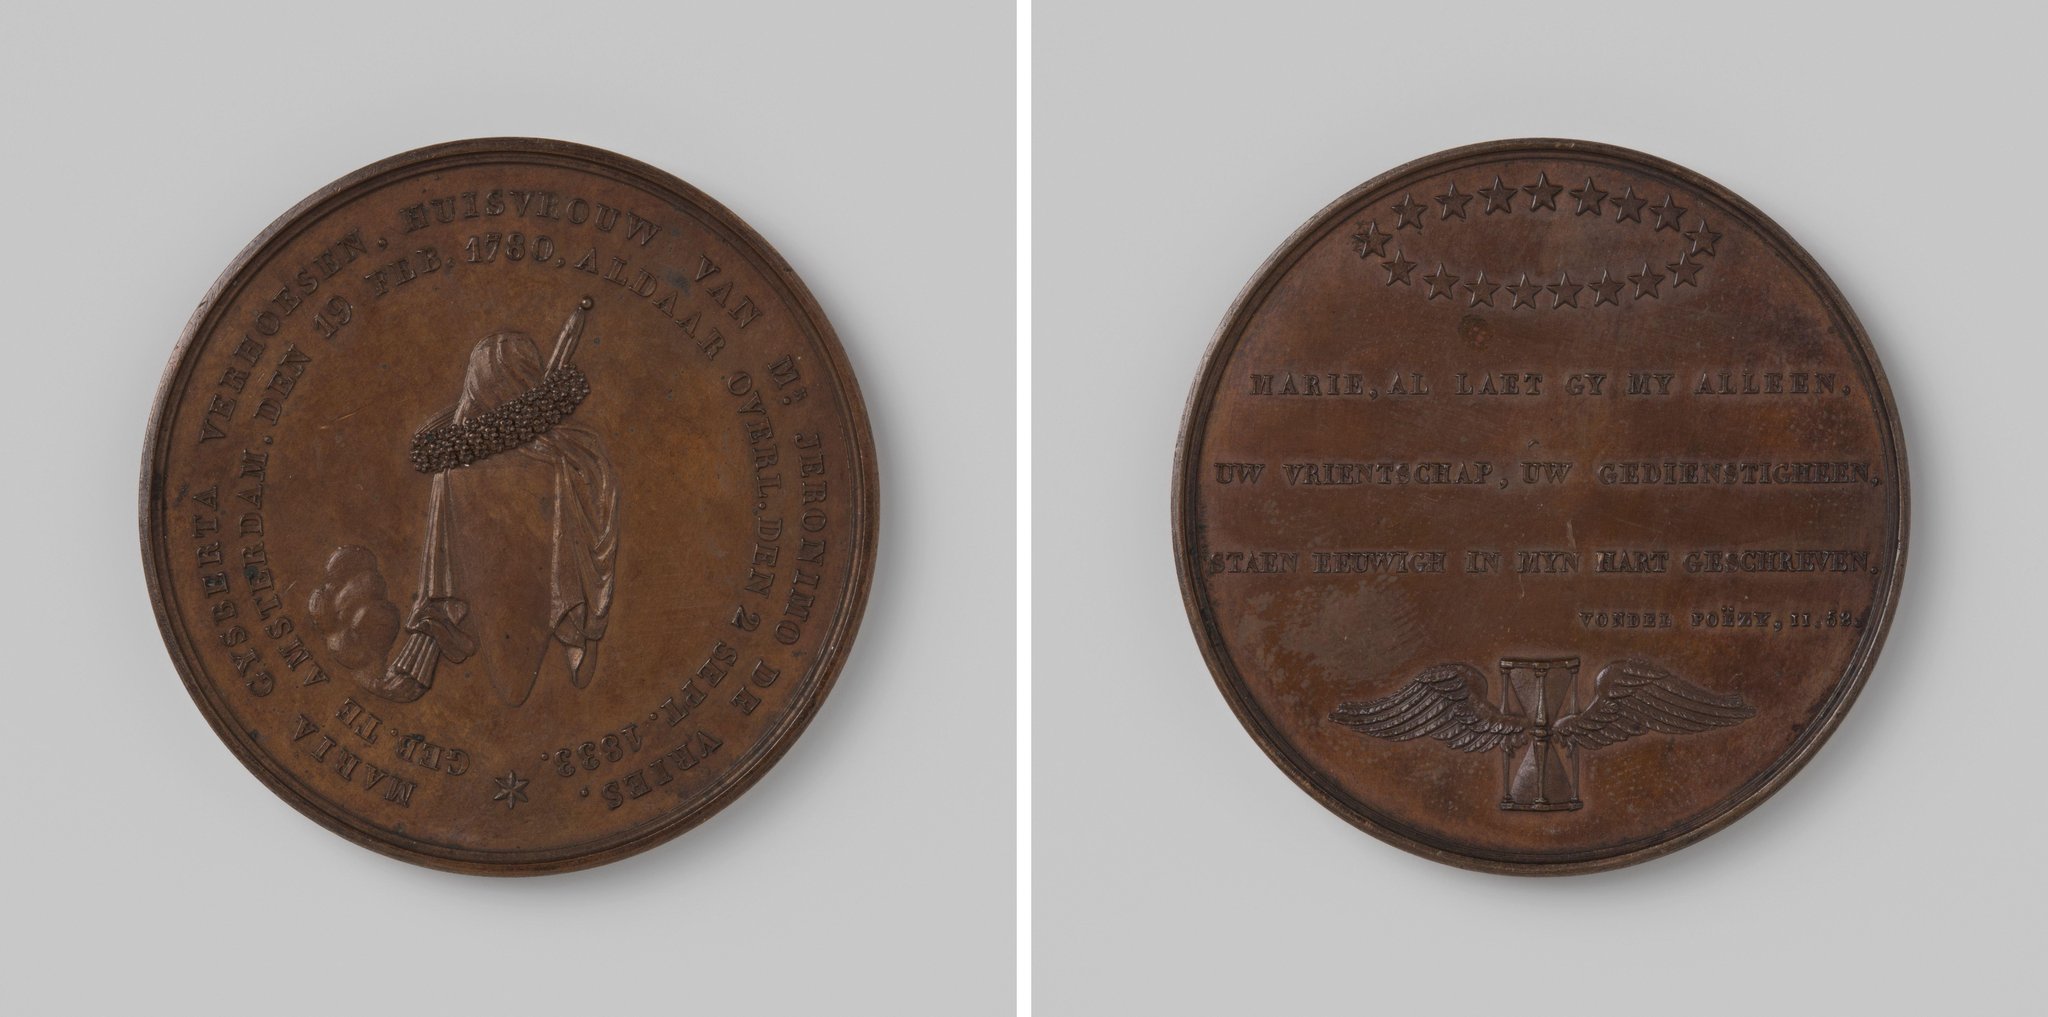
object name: family medal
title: Overlijden van Maria Gysberta Verhoesen, echtgenote van mr. Jeronimo de Vries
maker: Anonymous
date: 1833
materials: bronze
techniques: striking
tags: amsterdam, jeronimo de vries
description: Bronzen penning. Voorzijde: Romeinse amphoor, dienend als lijkbus, waarover kleed en bloemenkranshangen; daarachter omgekeerde, gedoofde fakkel binnen tweeregelig omschrift. Keerzijde: opschrift onder sterrekrans en boven gevleugelde zandloper